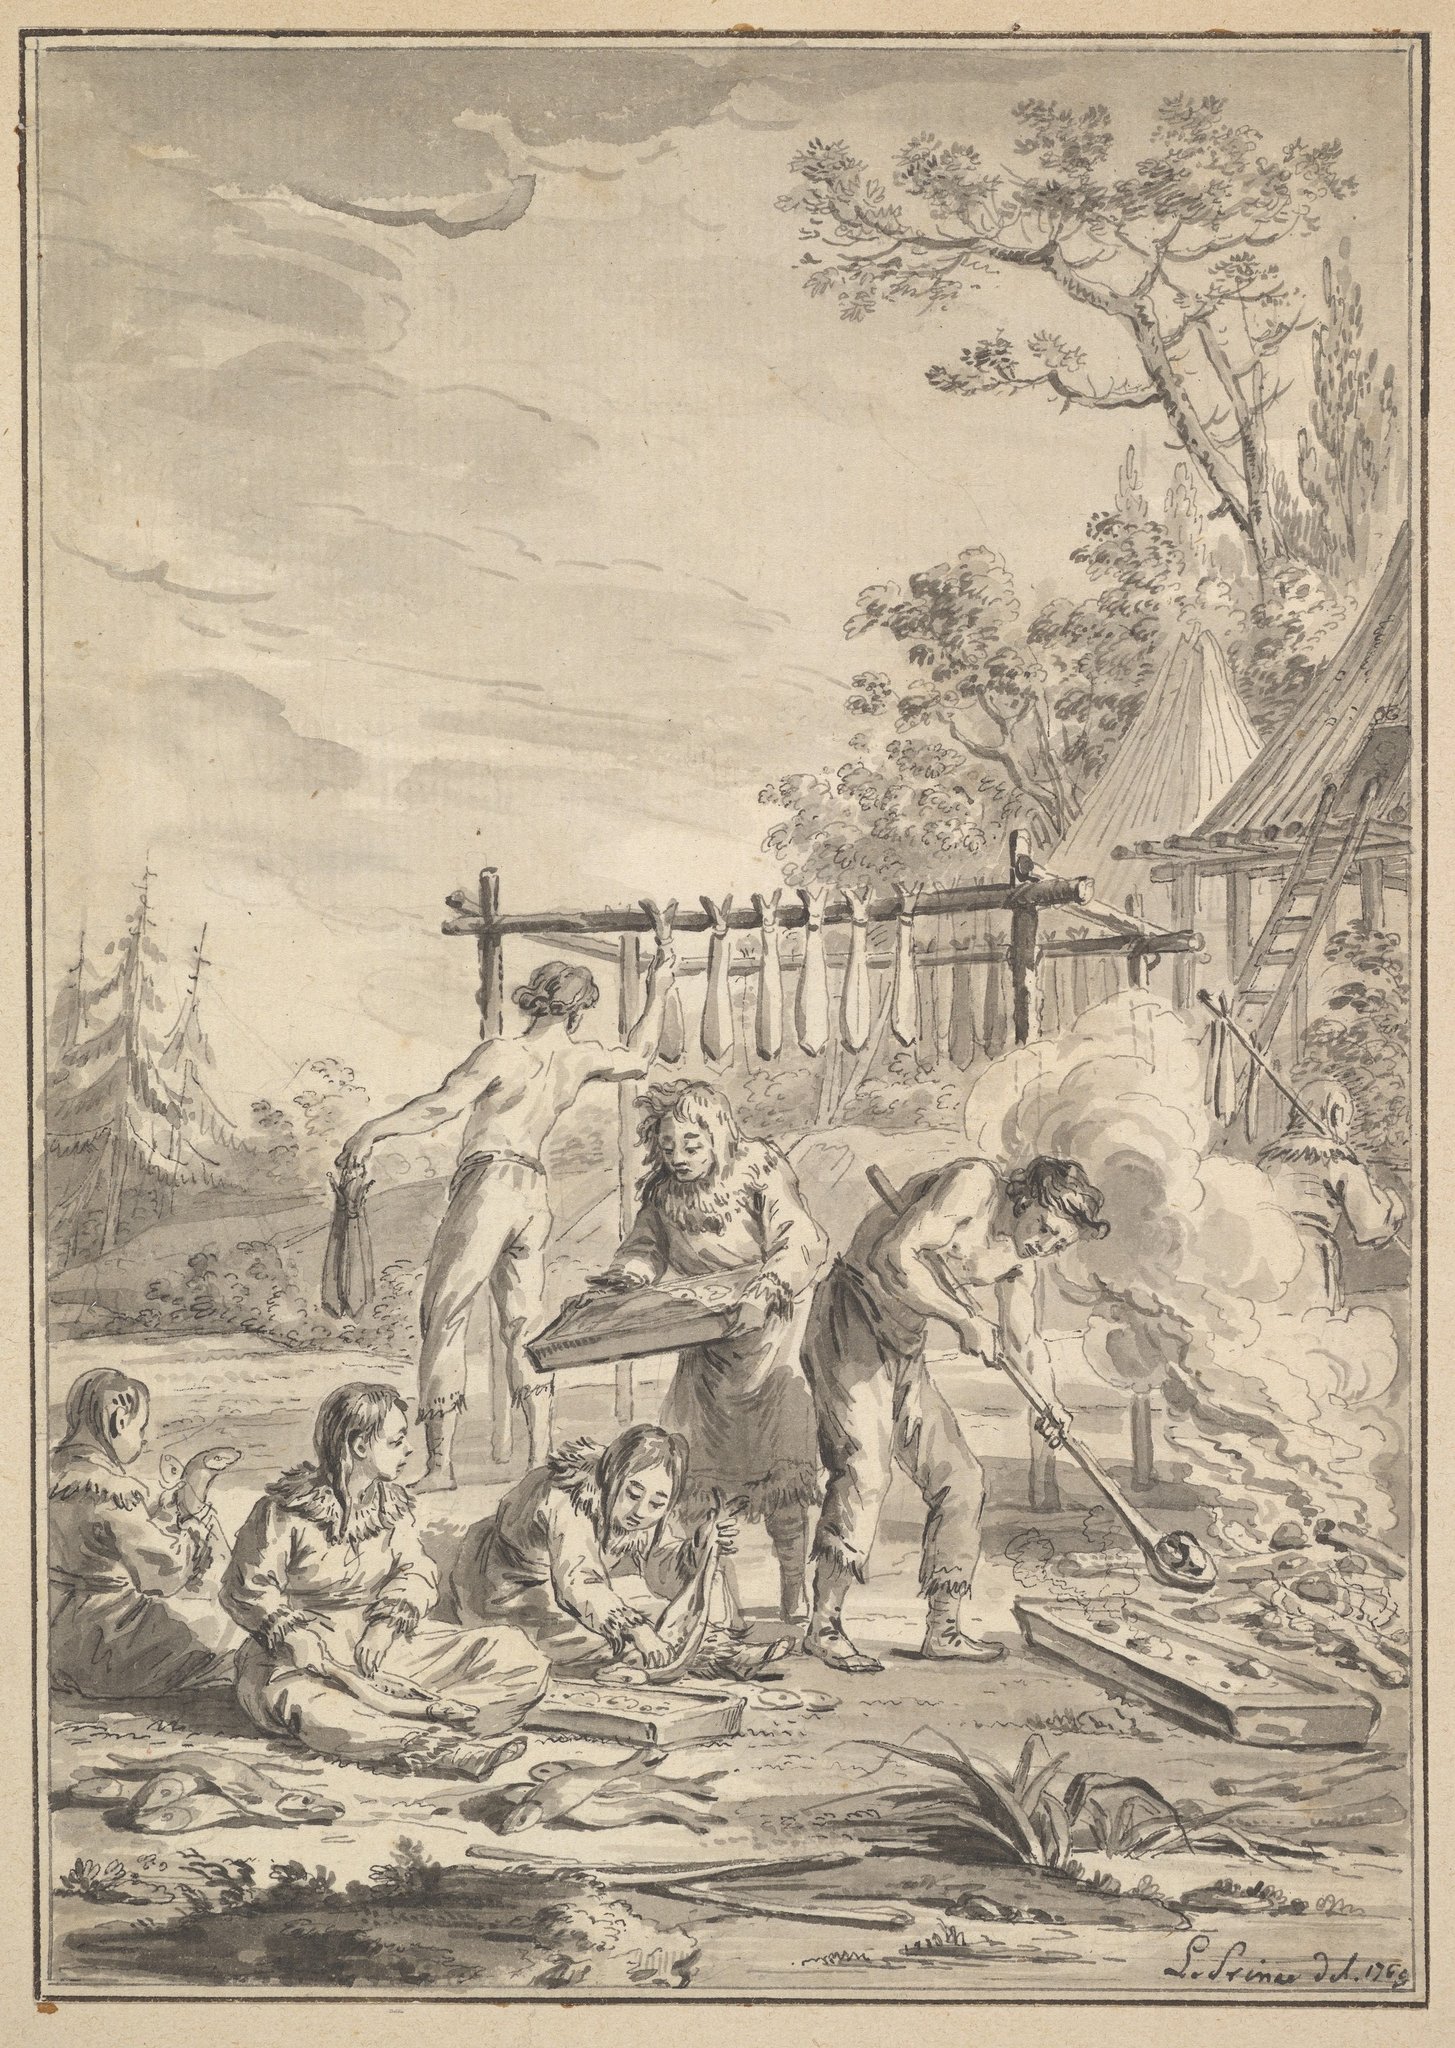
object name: drawing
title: Itelmen Preparing Fish to be Dried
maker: jean-baptiste le prince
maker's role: artist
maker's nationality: french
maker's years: 1734-1781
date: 1769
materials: chalk, ink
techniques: brush, pen, wash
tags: men,women,fish,working